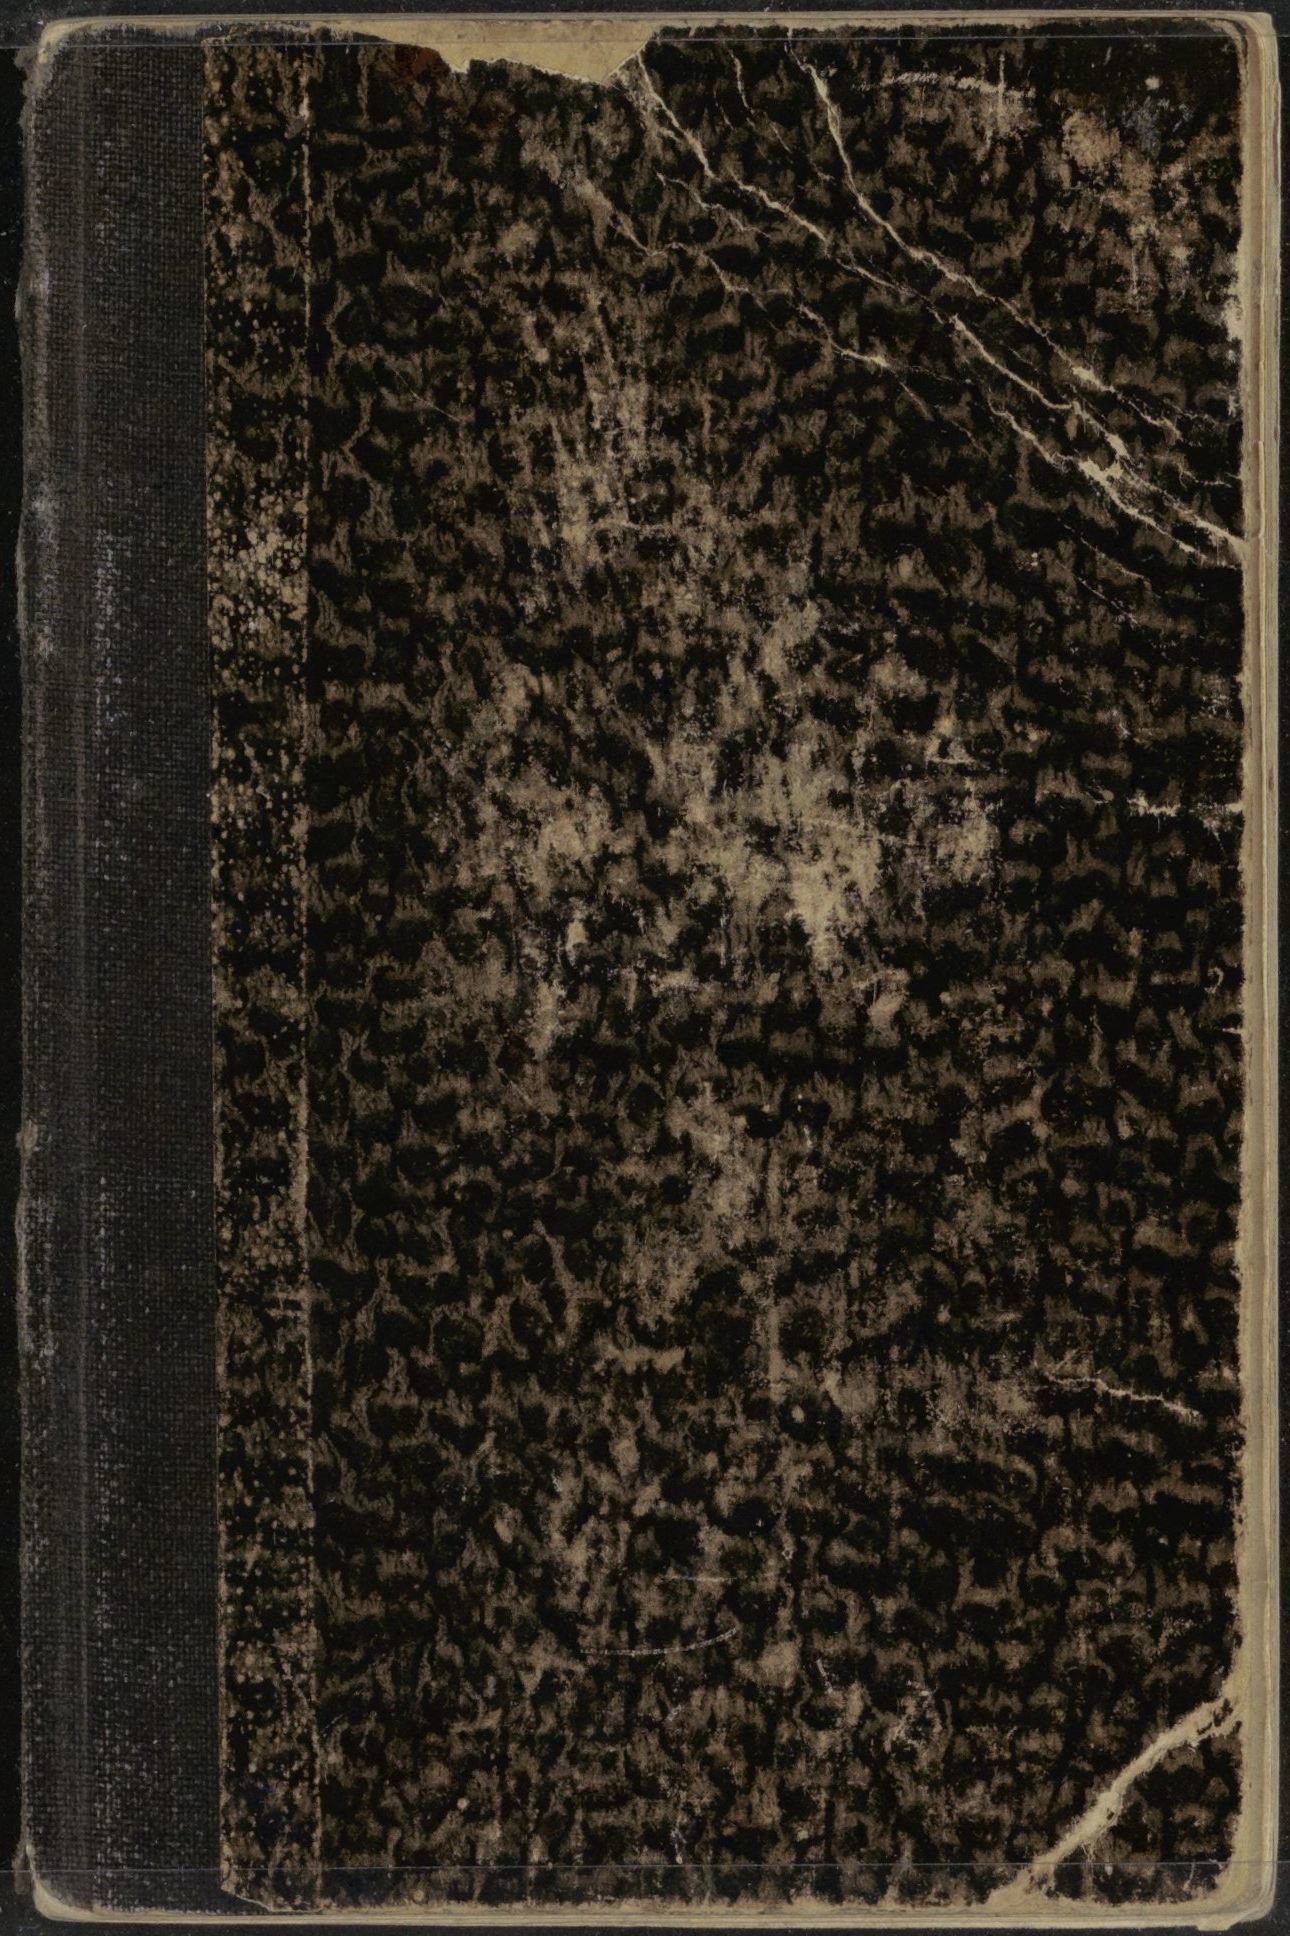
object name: sketchbook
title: Schetsboek met 46 bladen vervaardigd te Amsterdam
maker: george hendrik breitner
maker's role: draughtsman, painter, print maker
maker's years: 1857-1923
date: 1900-1901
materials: cardboard, chalk, linen, paper, pencil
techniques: marbling, stumping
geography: amsterdam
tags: urban housing, city-view, and landscape with man-made constructions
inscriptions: retailer's mark: ‘Gebrs. Simons/ Amsterdam./ Filiaal/ Heiligenweg 34/ Kantoorboek & Papierhandel./ Linieer- en Perforeer-inrichting./ No. 141 Blanco/ Bij nabestelling van dit boek, gelieve men/ bovenstaand nummer op te geven. / per doz f 1.60 per stuk 15’, workshop stamp: ‘G.H. Breitner’, annotation: ‘Bouwrij v. Lennepkwartier/ afbraak Damrak (Dake)/ Schepen a/d Ruiterkade avond/ Bouwrij in Lennepkwartier/ Grondkruijers/ Damrak drukke zijde/ N. Teertuinen oude boomen/ afbraak leesmuseum/ Damrak gezien uit no. 56 Warmoestraat [sic]/ Damrak gez. a.d. nieuwe brug/ allerlei schepen./ Tram. Schepen./ straat met vlagen [sic]/ O.Z. Kolk/ Rokin K Arti. (Pres. Kruger verwacht)/ Oude boom Overtoom/ Damrak, achterzijde Warmoesstraat/ Grondkruijers/ Overtoom met schepen/ Rokin met tram uit Arti/ Zandkruijers met schepen a/h Vondelpark/ Stadhouderskade/ Bouwrij v. Lennep buurt/ afbraak Damrak (Dake)/ Rokin uit Arti [...]/ Bouwrij v. Lennepbuurt a/ Overtoom’, collector's mark: Lugt 2228, date: ‘1901’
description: Schetsboek bestaande uit 46 bladen met gezichten te Amsterdam.